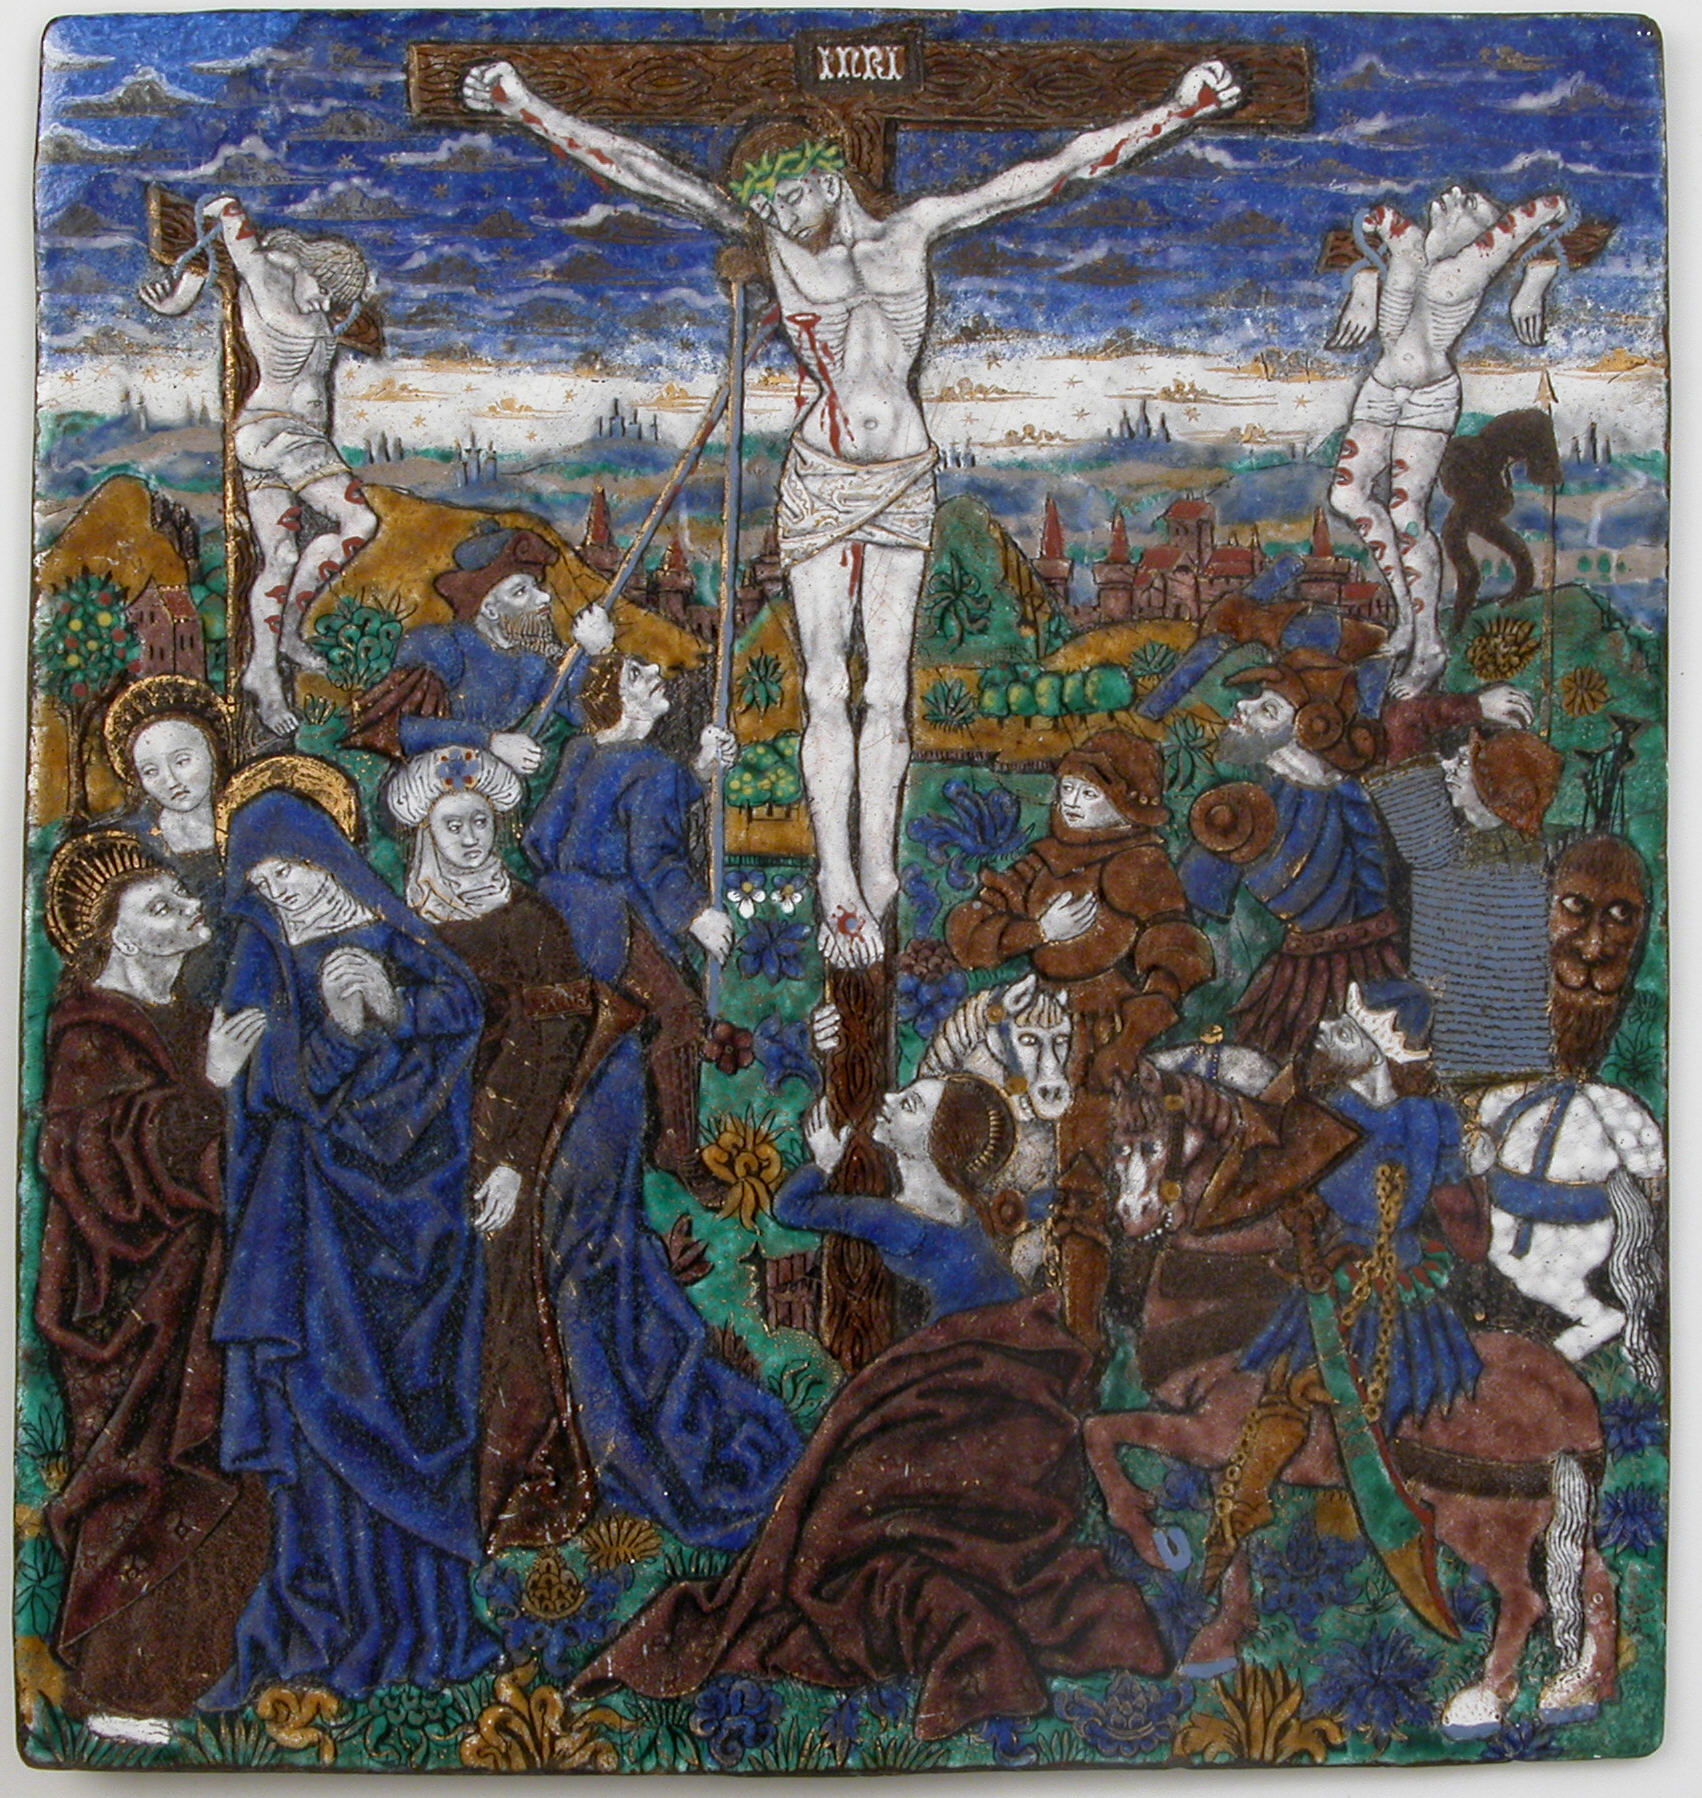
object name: plaque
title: Plaque with the Crucifixion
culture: french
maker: monvaerni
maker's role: artist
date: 1401-1500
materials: copper, enamel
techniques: painting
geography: france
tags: men,women,christ,cross